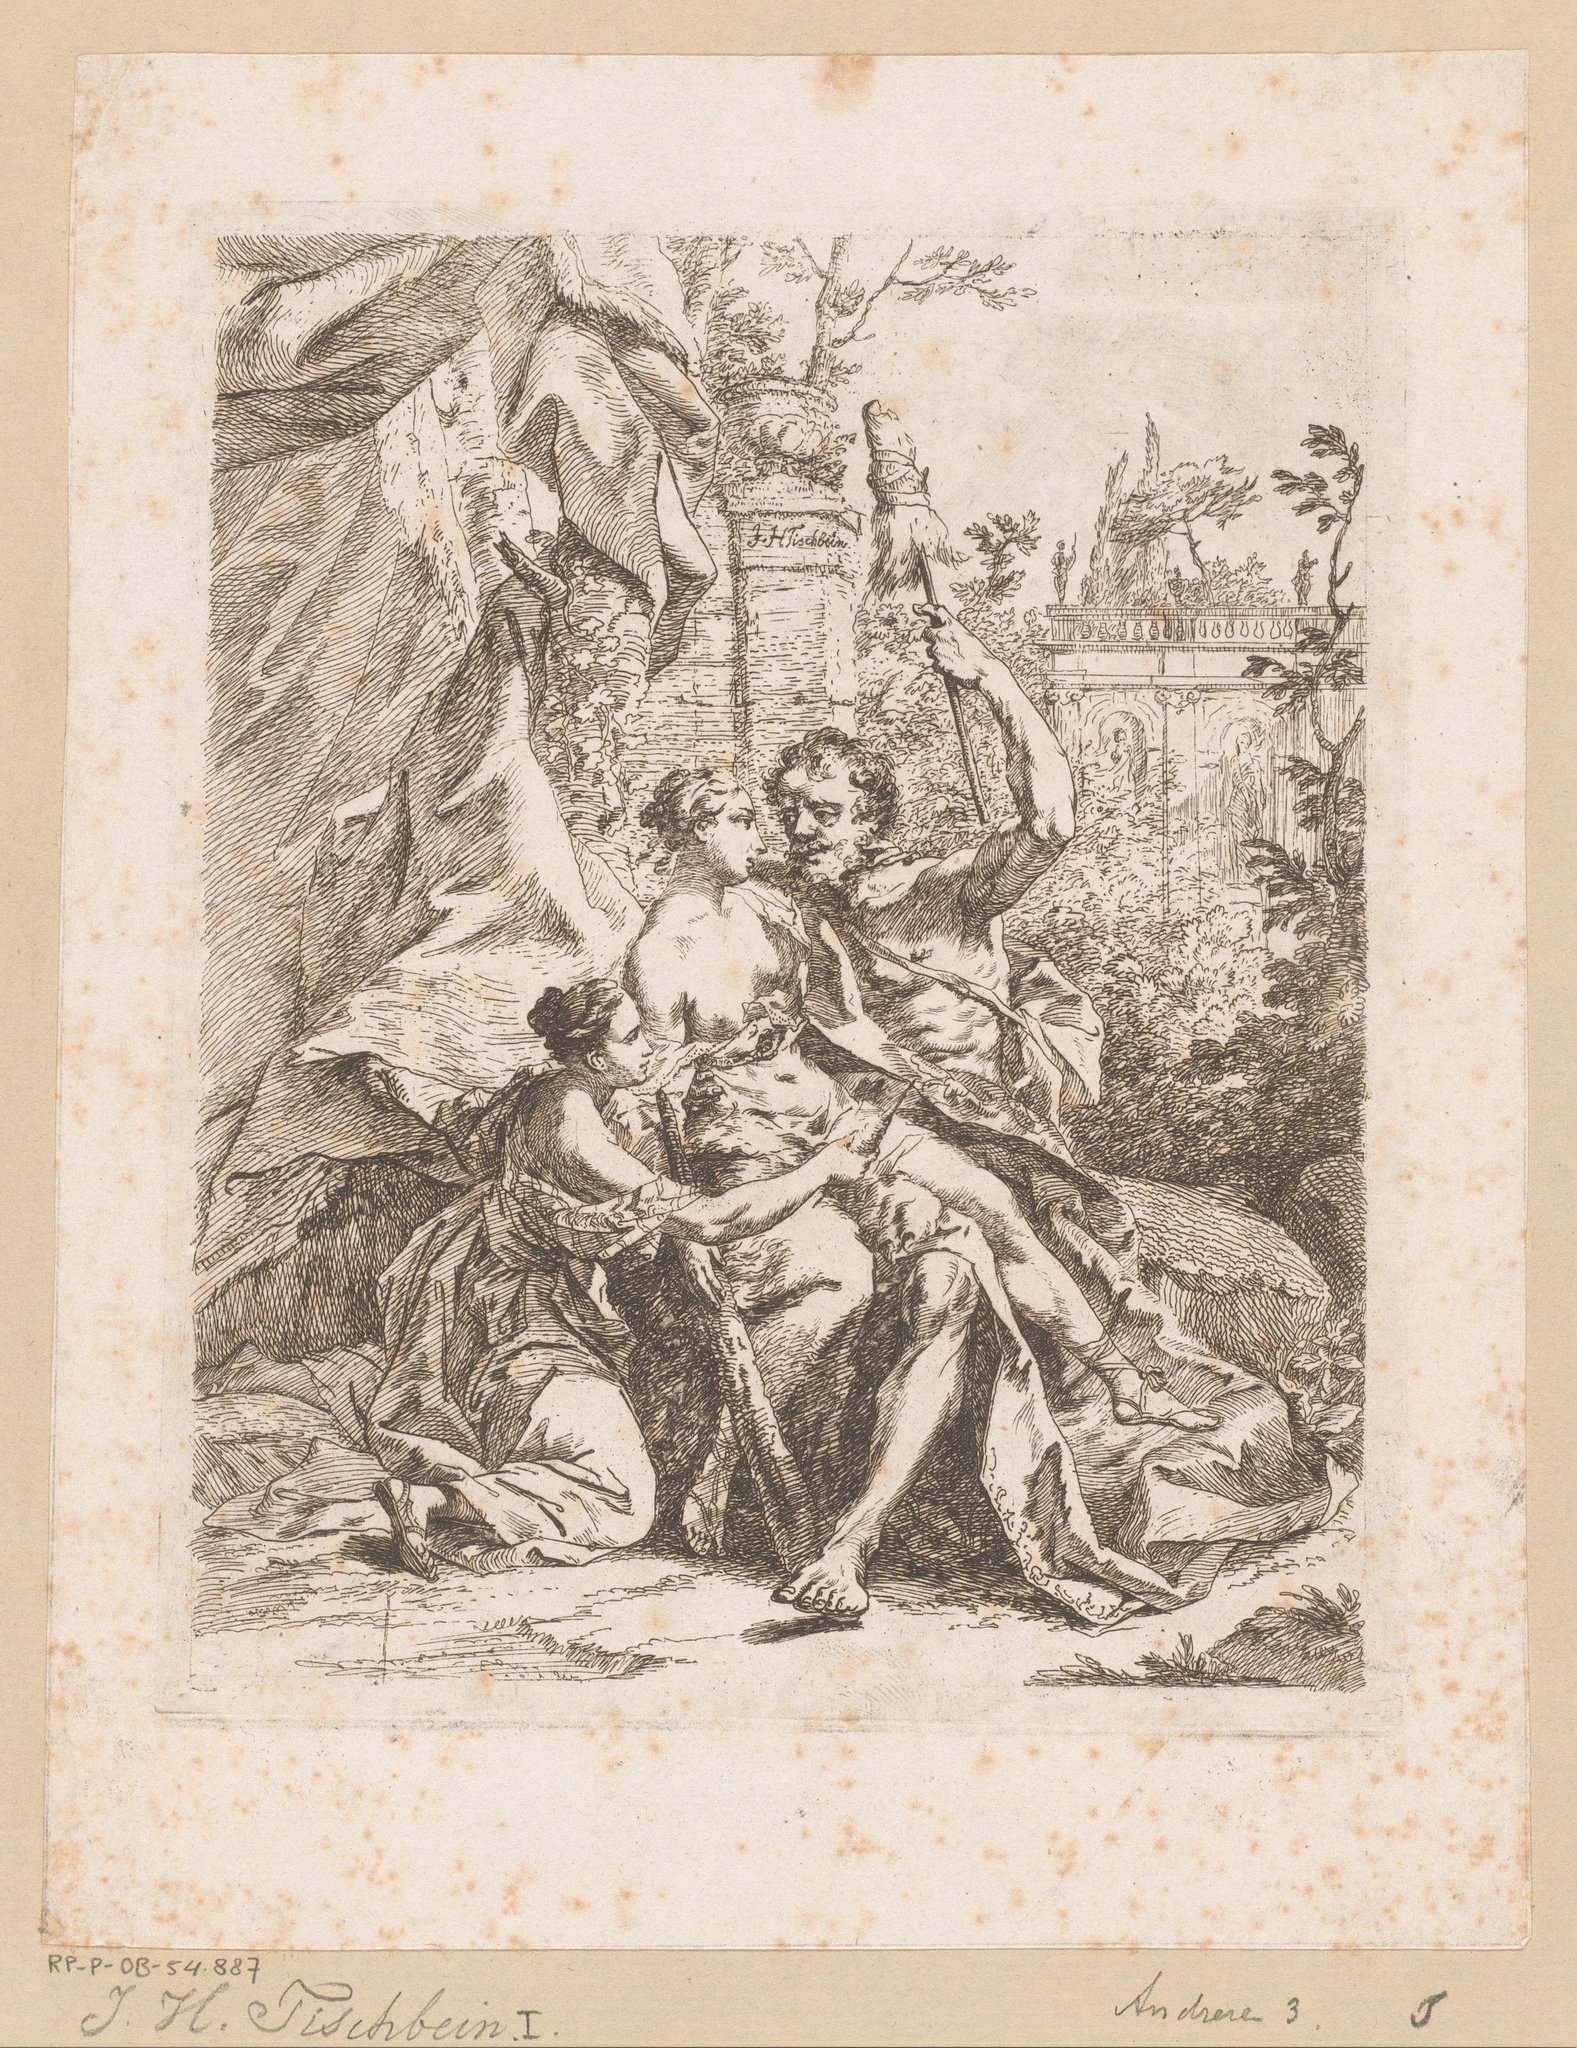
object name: print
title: Hercules en Omphale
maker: johann heinrich tischbein (1722-1789)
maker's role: draughtsman, painter, print maker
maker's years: 1722-1789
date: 1732-1789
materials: paper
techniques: etching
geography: germany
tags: hercules in love with omphale; the hero is set to spin wool or to do other women's work among the servants, while omphale wears his lion's skin and wields his club and bow, distaff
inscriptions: collector's mark: Lugt 240